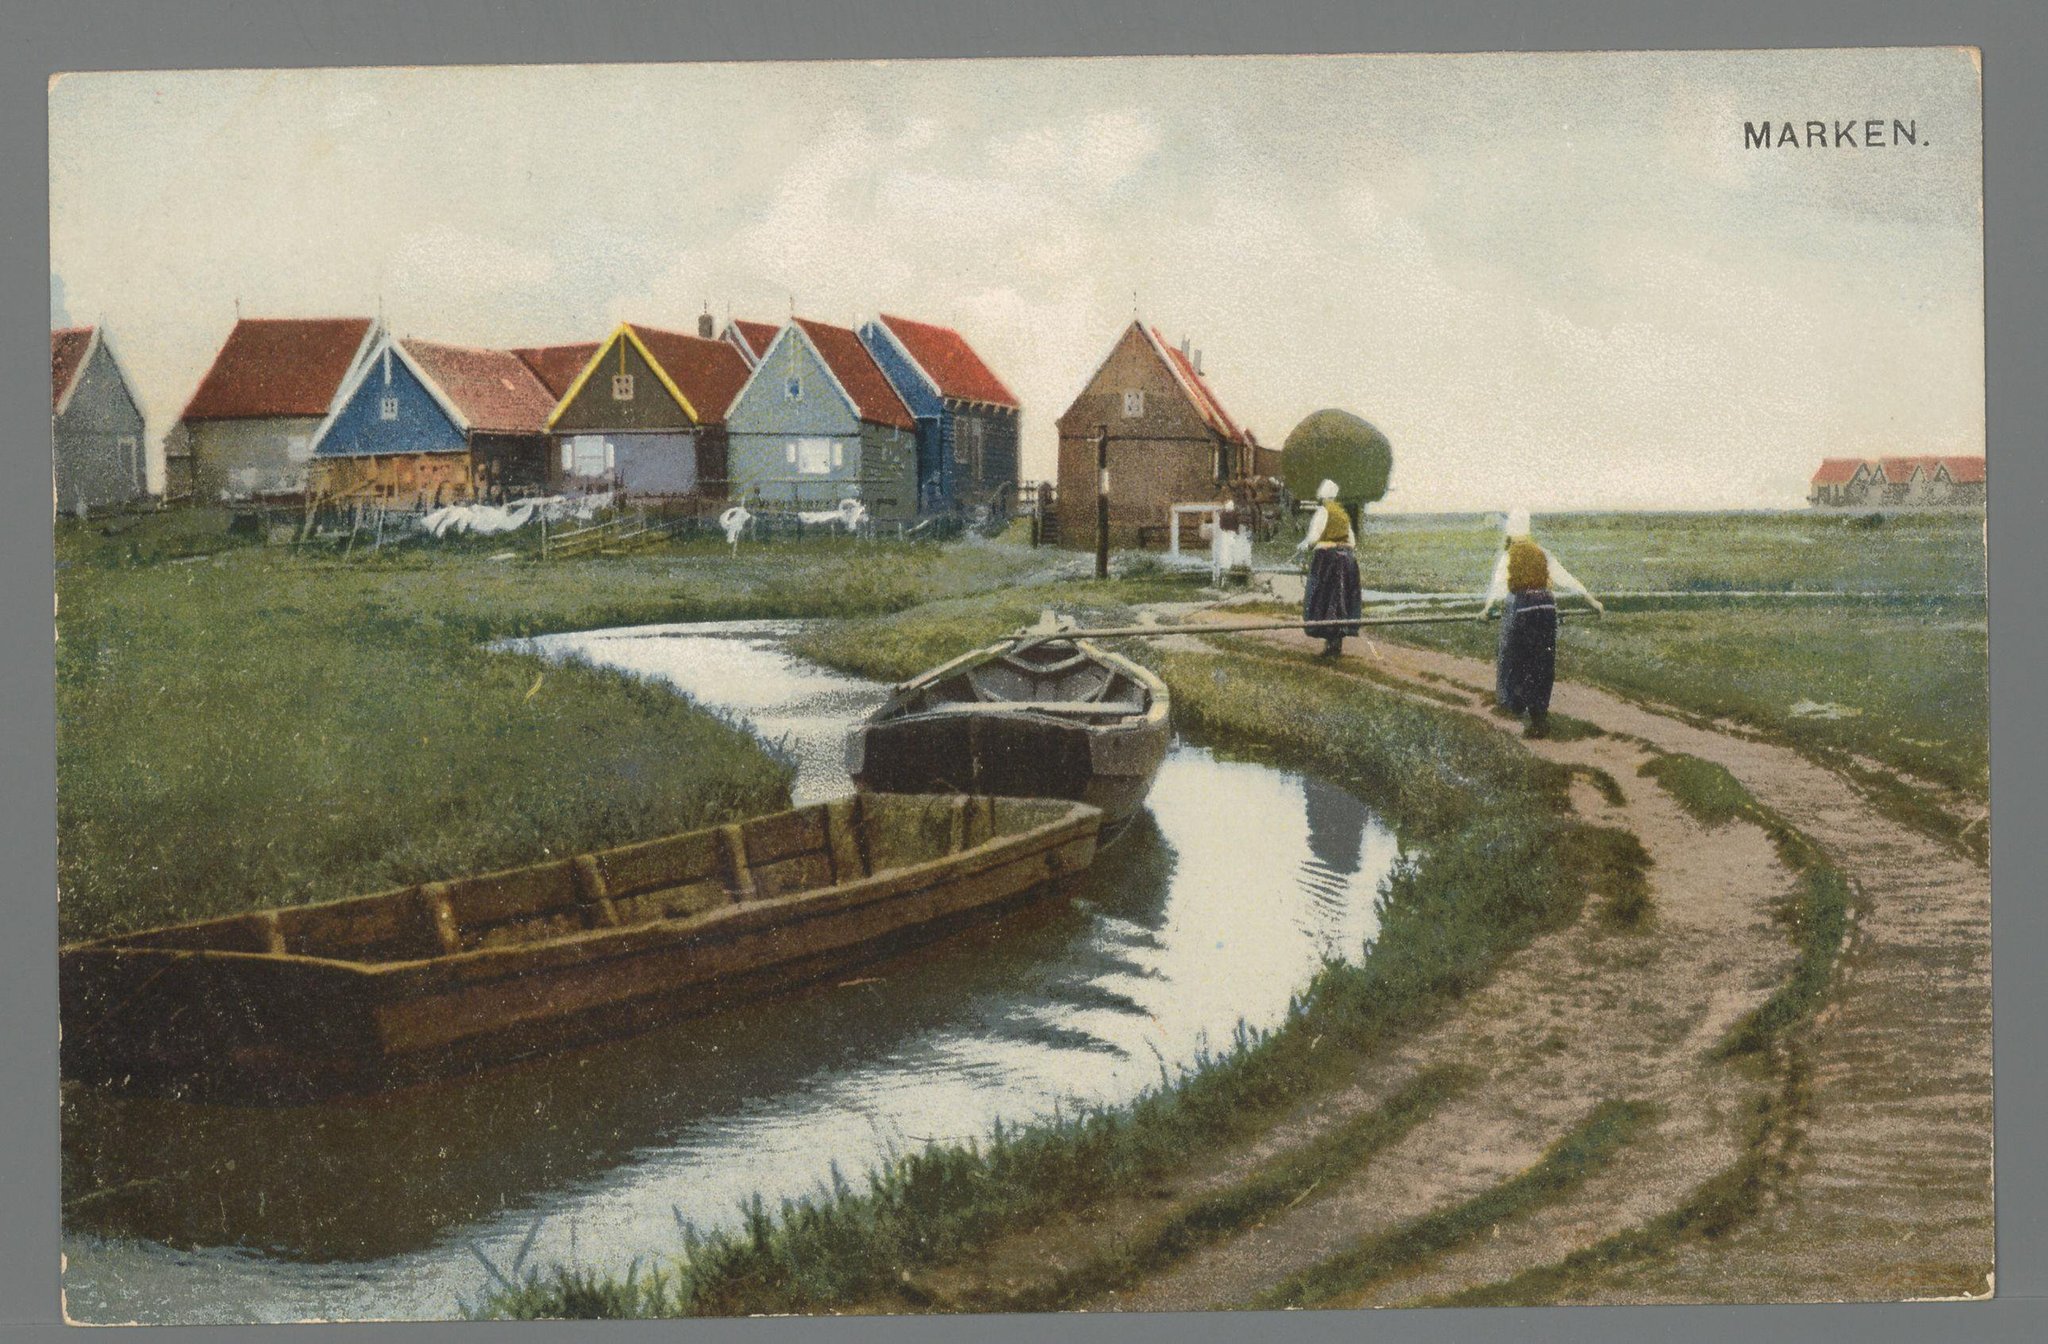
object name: photomechanical print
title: Marken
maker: Anonymous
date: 1906-1945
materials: cardboard, photographic process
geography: dresden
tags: canal, village, rowing-boat, canoe, etc.